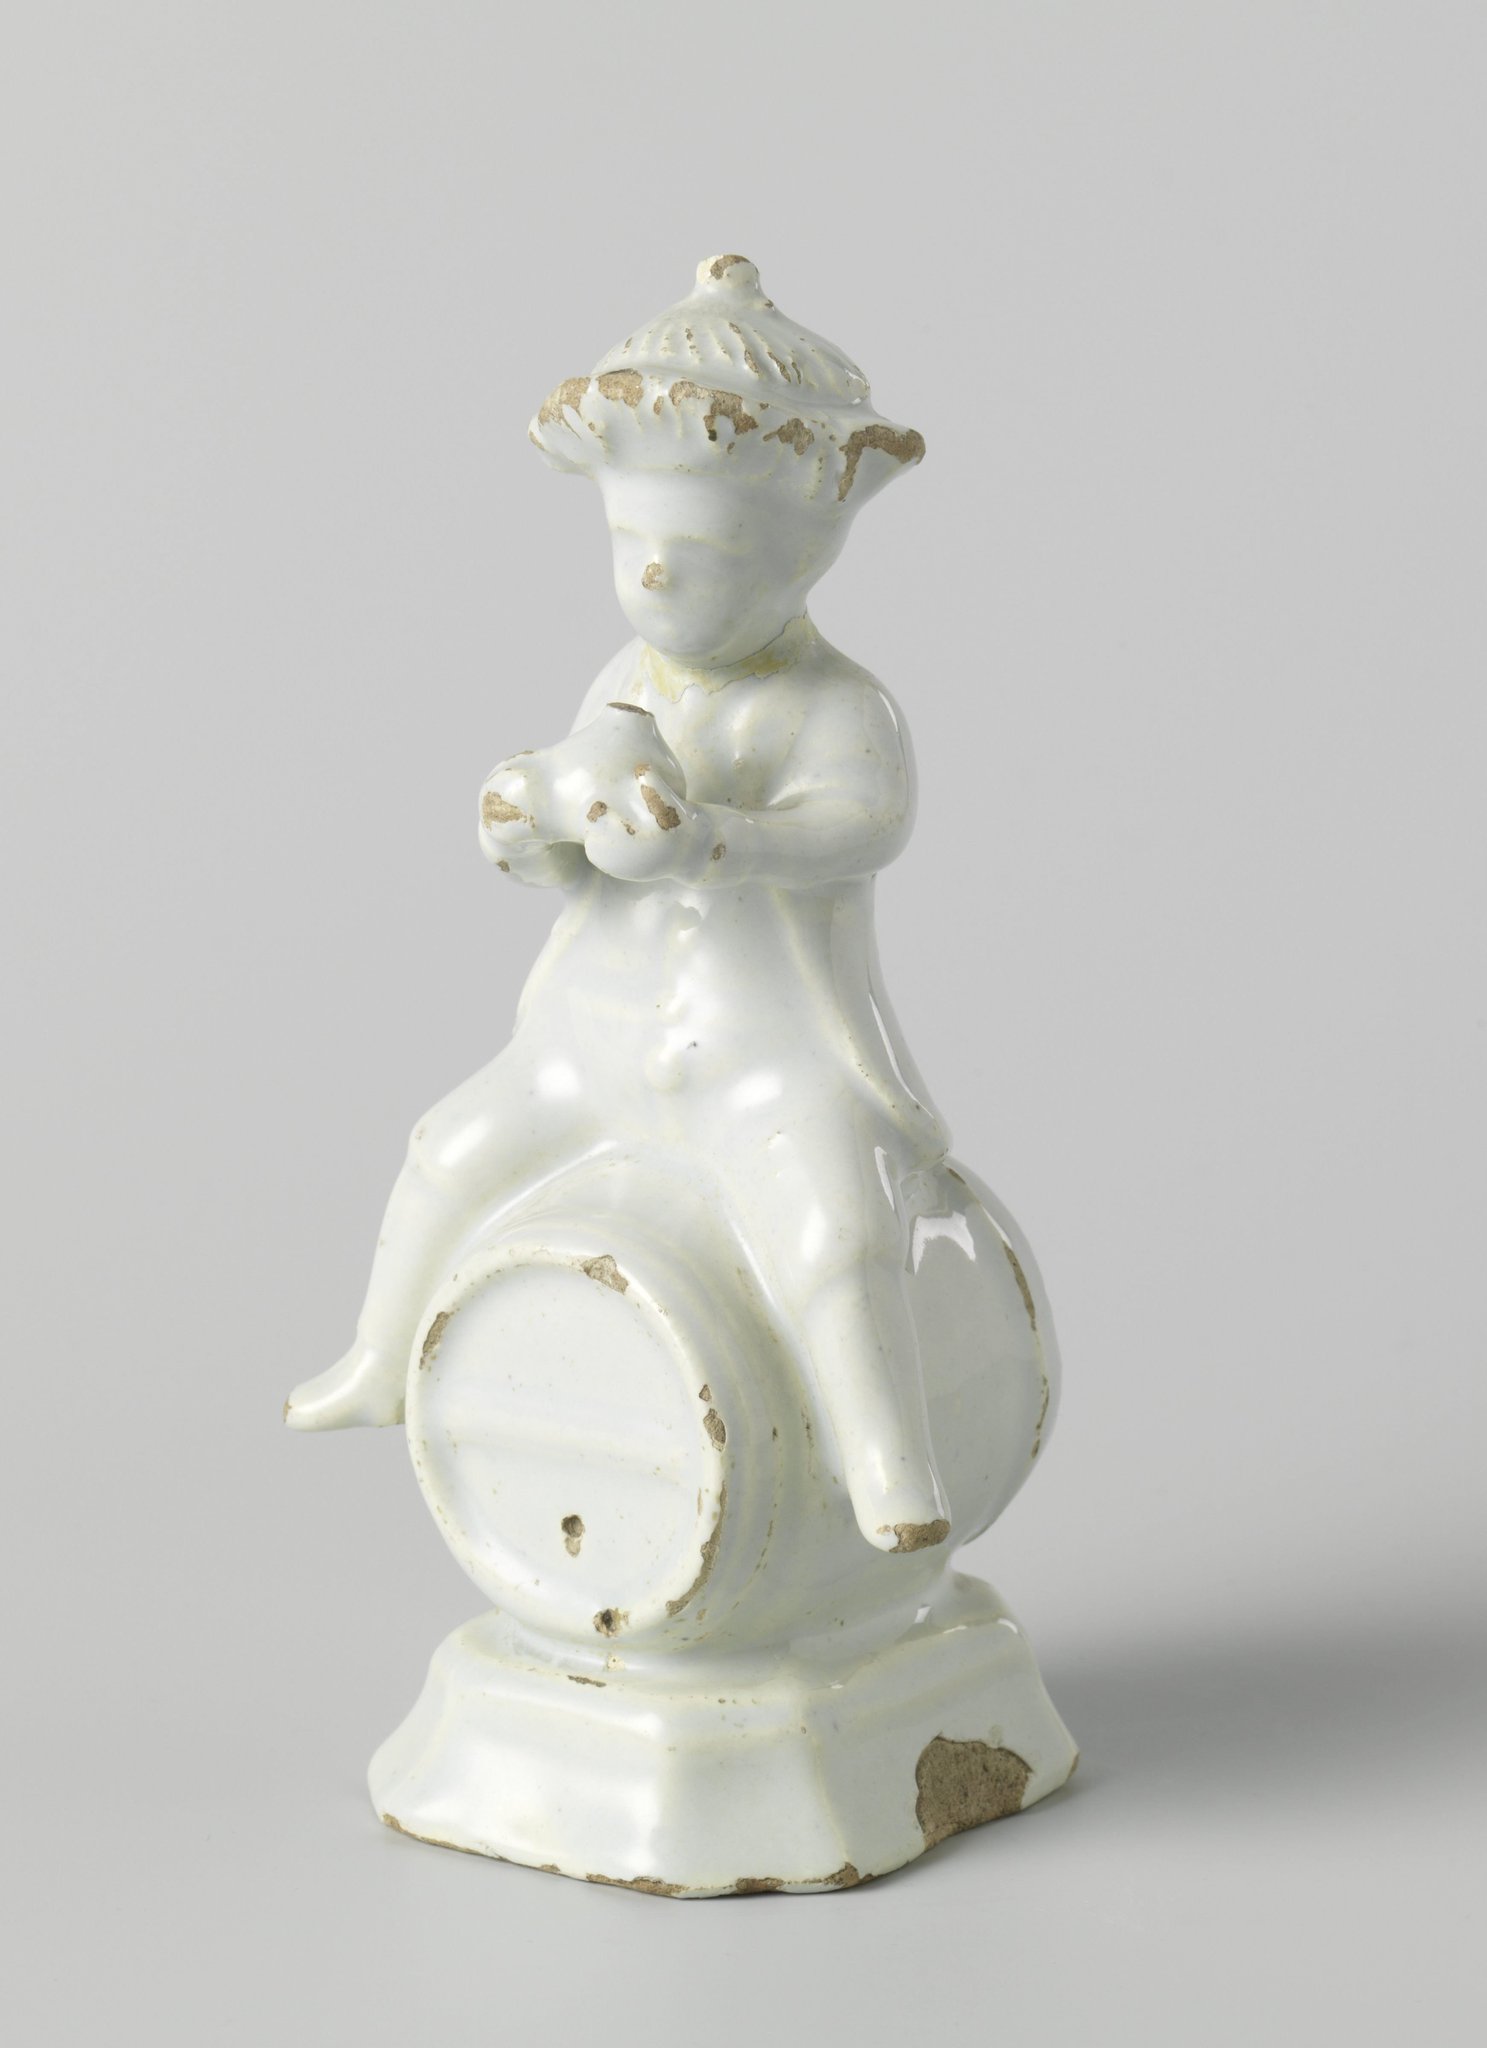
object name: decoratief object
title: Man met hoed en fles in de hand, op ton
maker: Anonymous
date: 1760-1790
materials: earthenware, glaze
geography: delft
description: Beeld van ongedecoreerde faience. Op een rechthoekig voetstuk met afgeschuinde hoeken ligt een ton. Op de ton zit een jongen met een hoed op zijn hoofd en een fles in zijn handen.